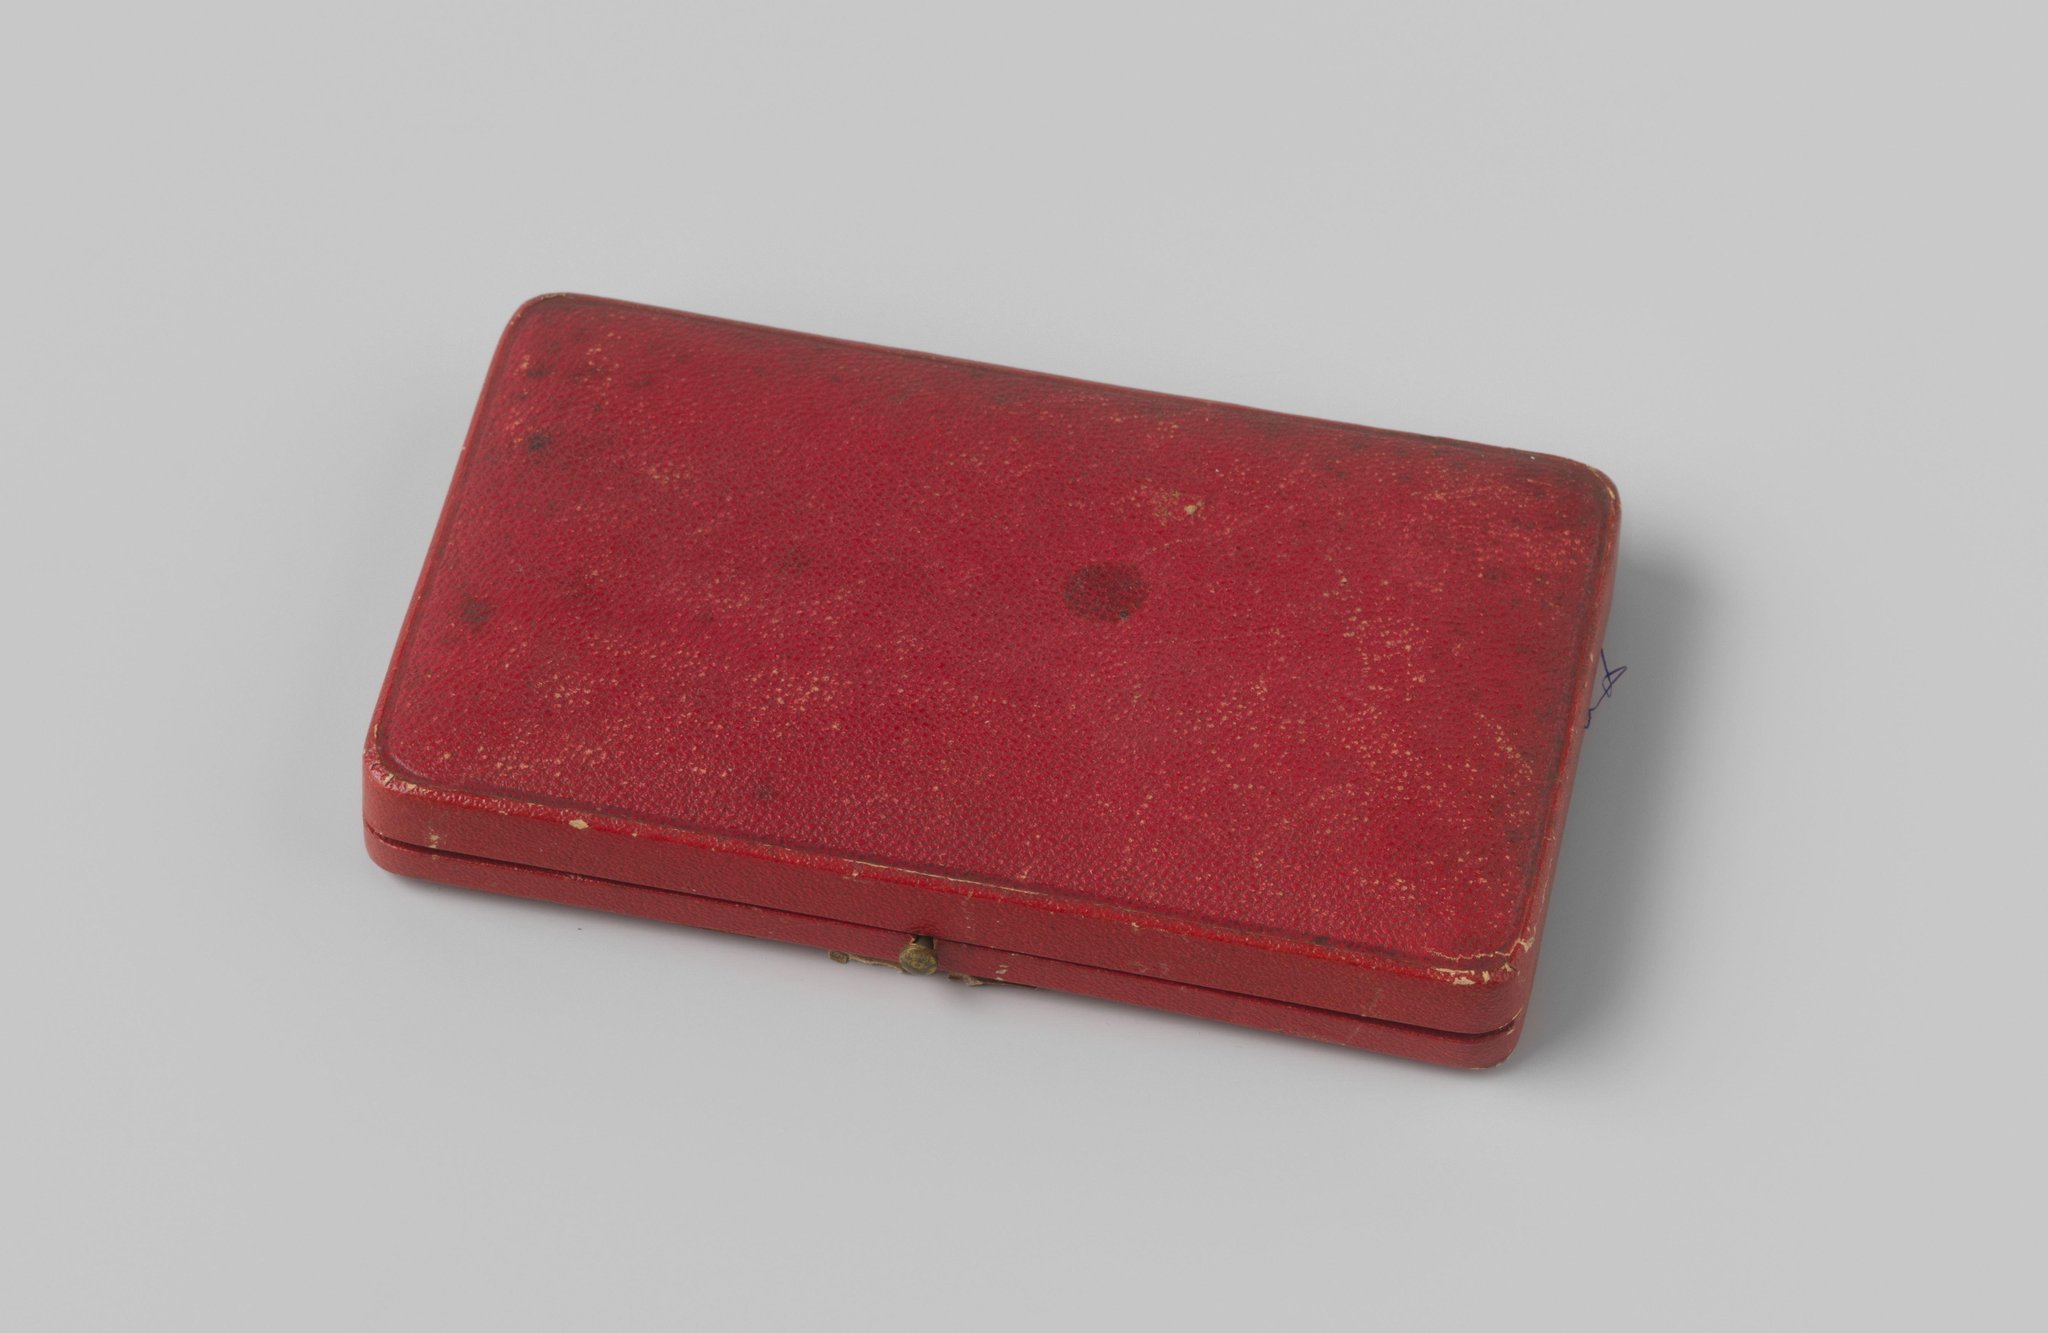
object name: étui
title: Rood leren etui behorend bij penningen van de opening van het Noordzeekanaal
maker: Anonymous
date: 1876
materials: copper, leather, silk, velvet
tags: brussels, willem iii (koning der nederlanden)